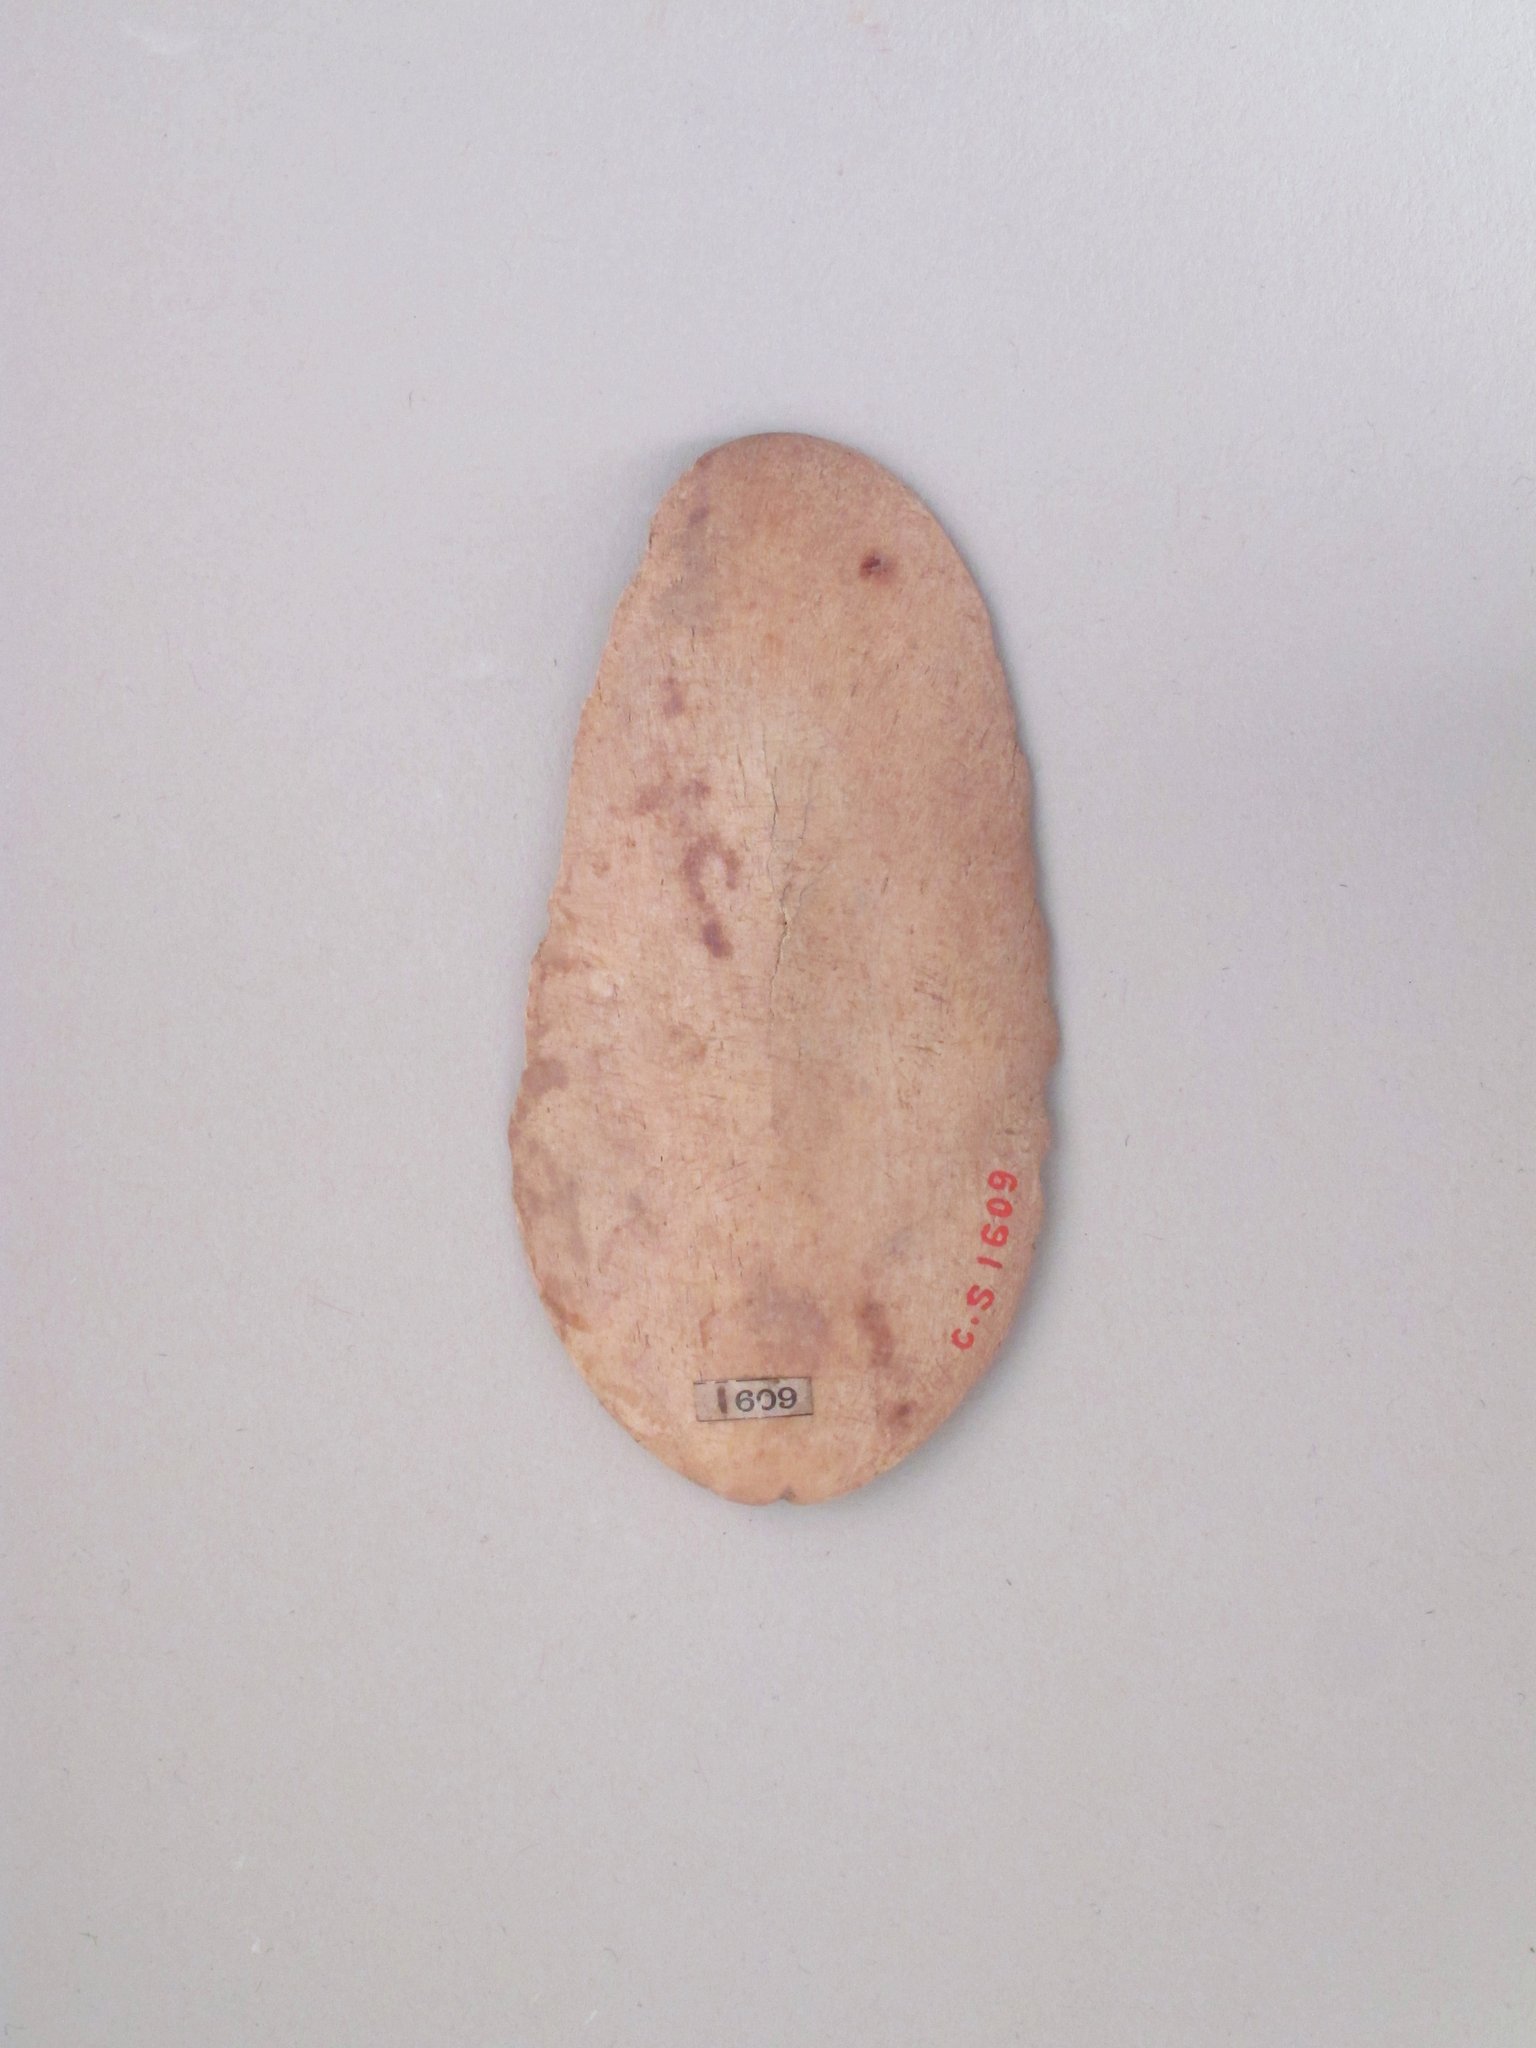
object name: spoon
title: Bone spoon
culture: cypriot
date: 7000 BCE-330 CE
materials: bone